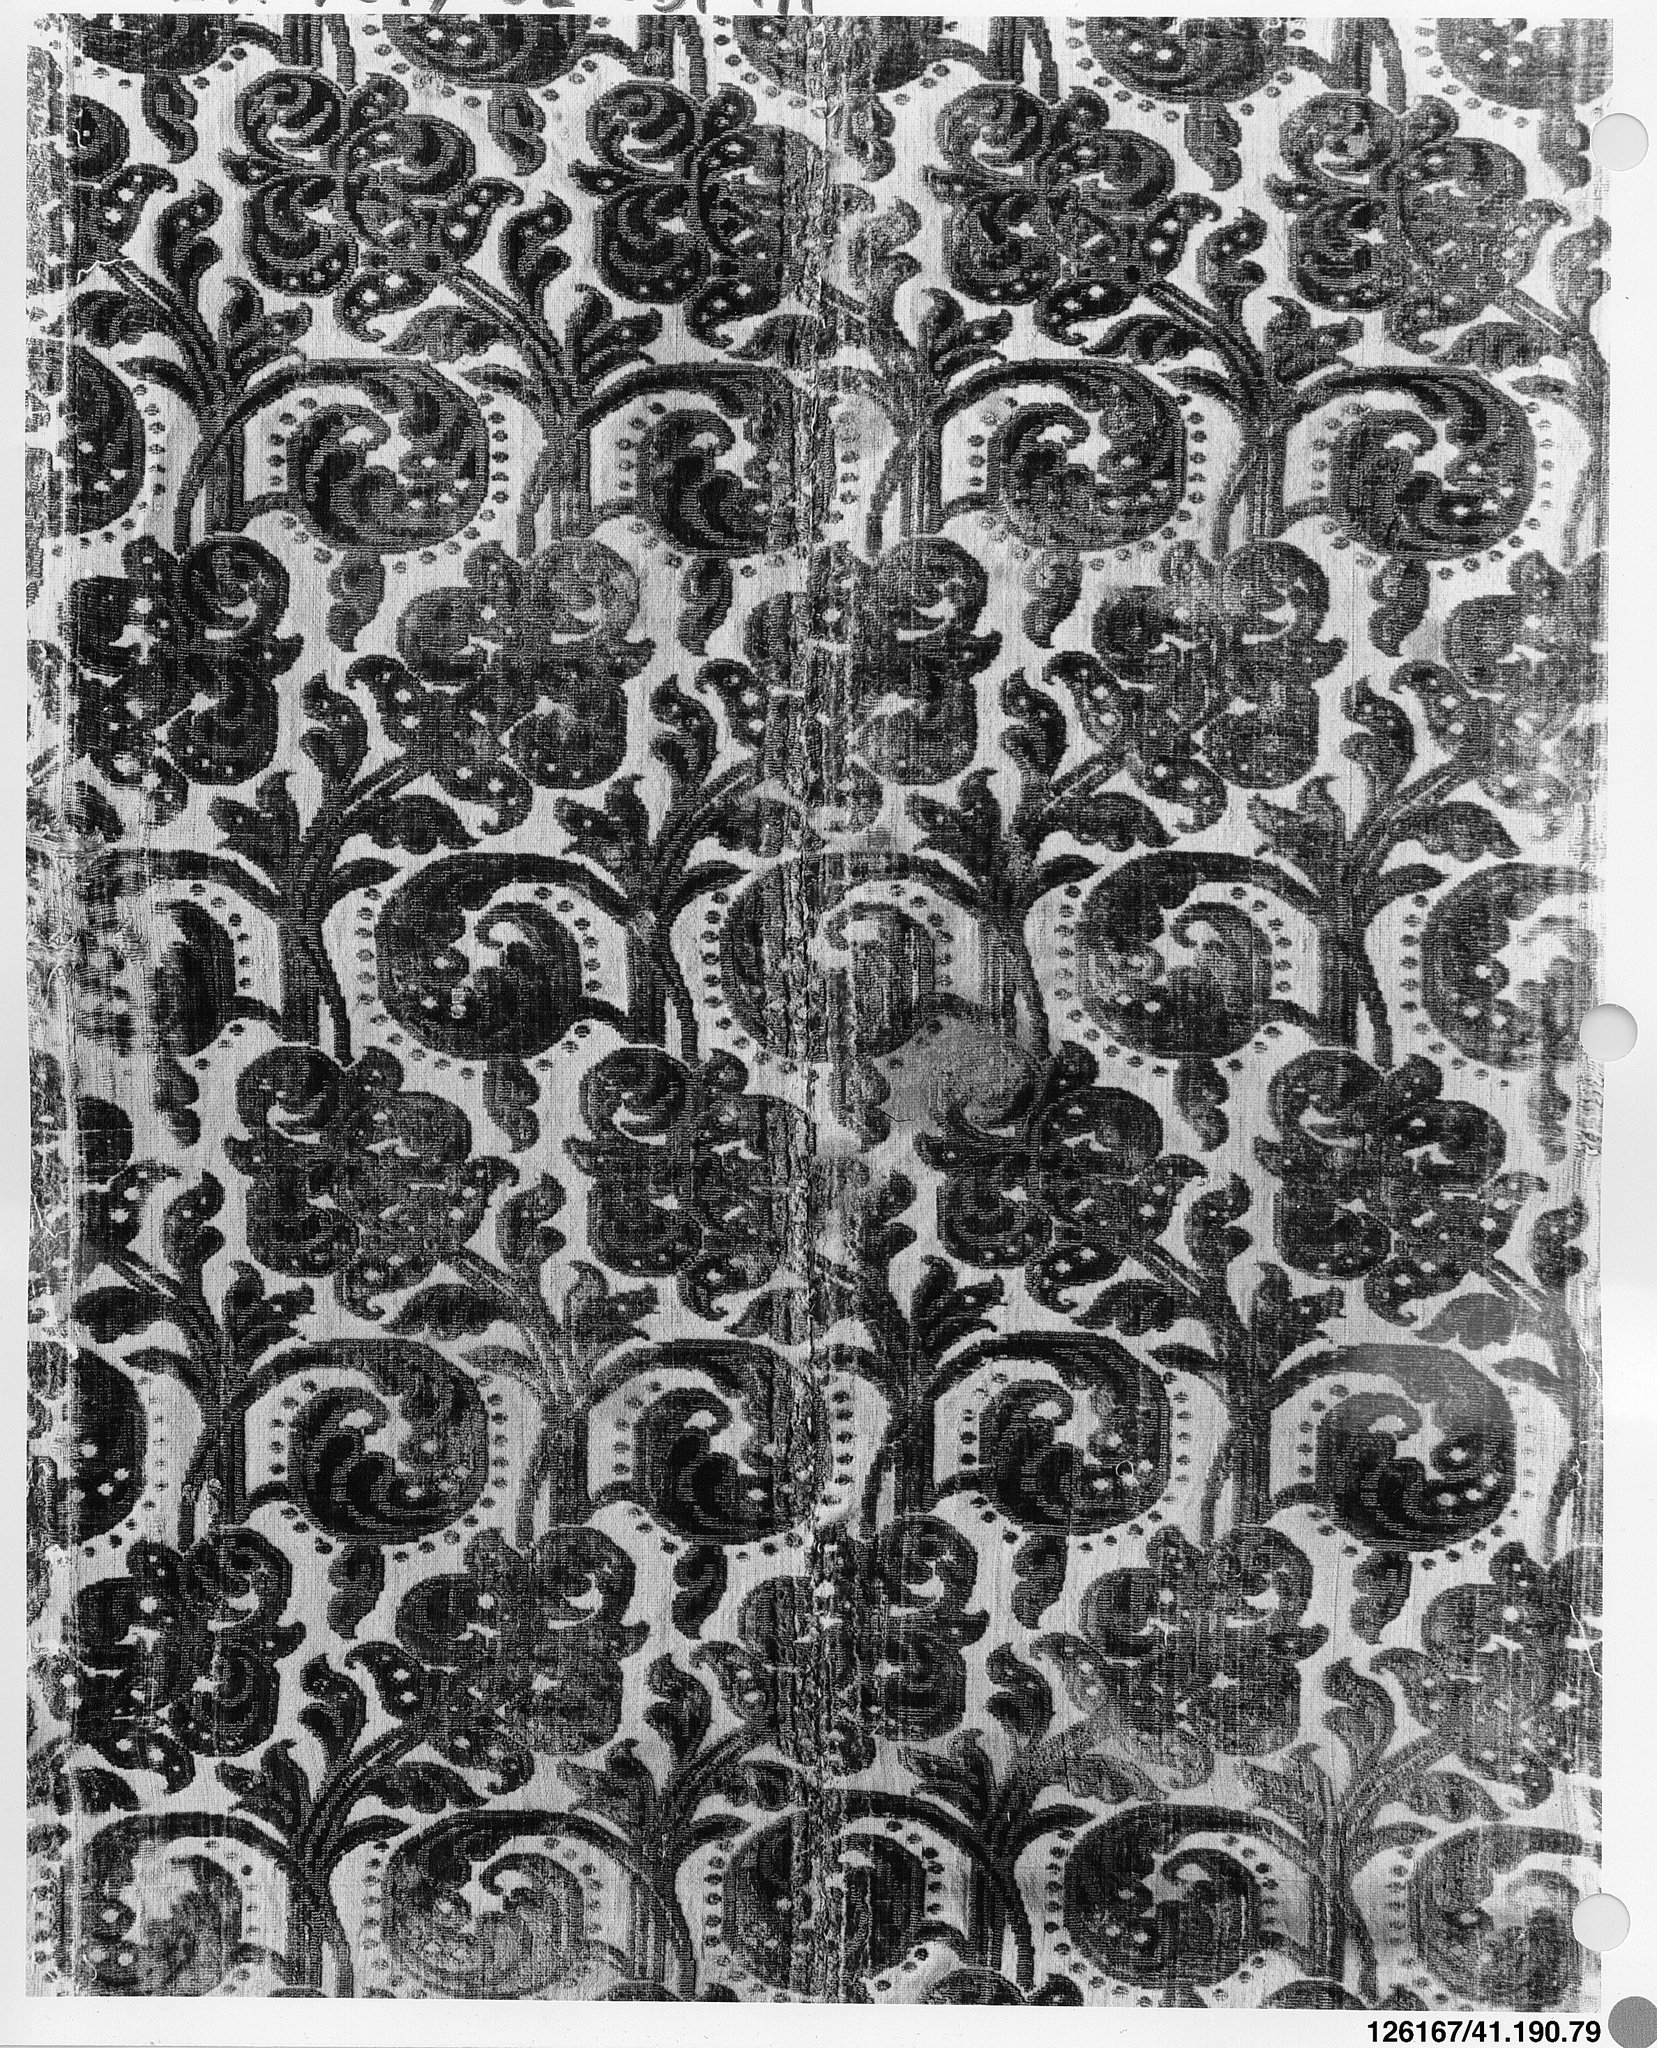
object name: piece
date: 1501-1600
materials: silk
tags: leaves